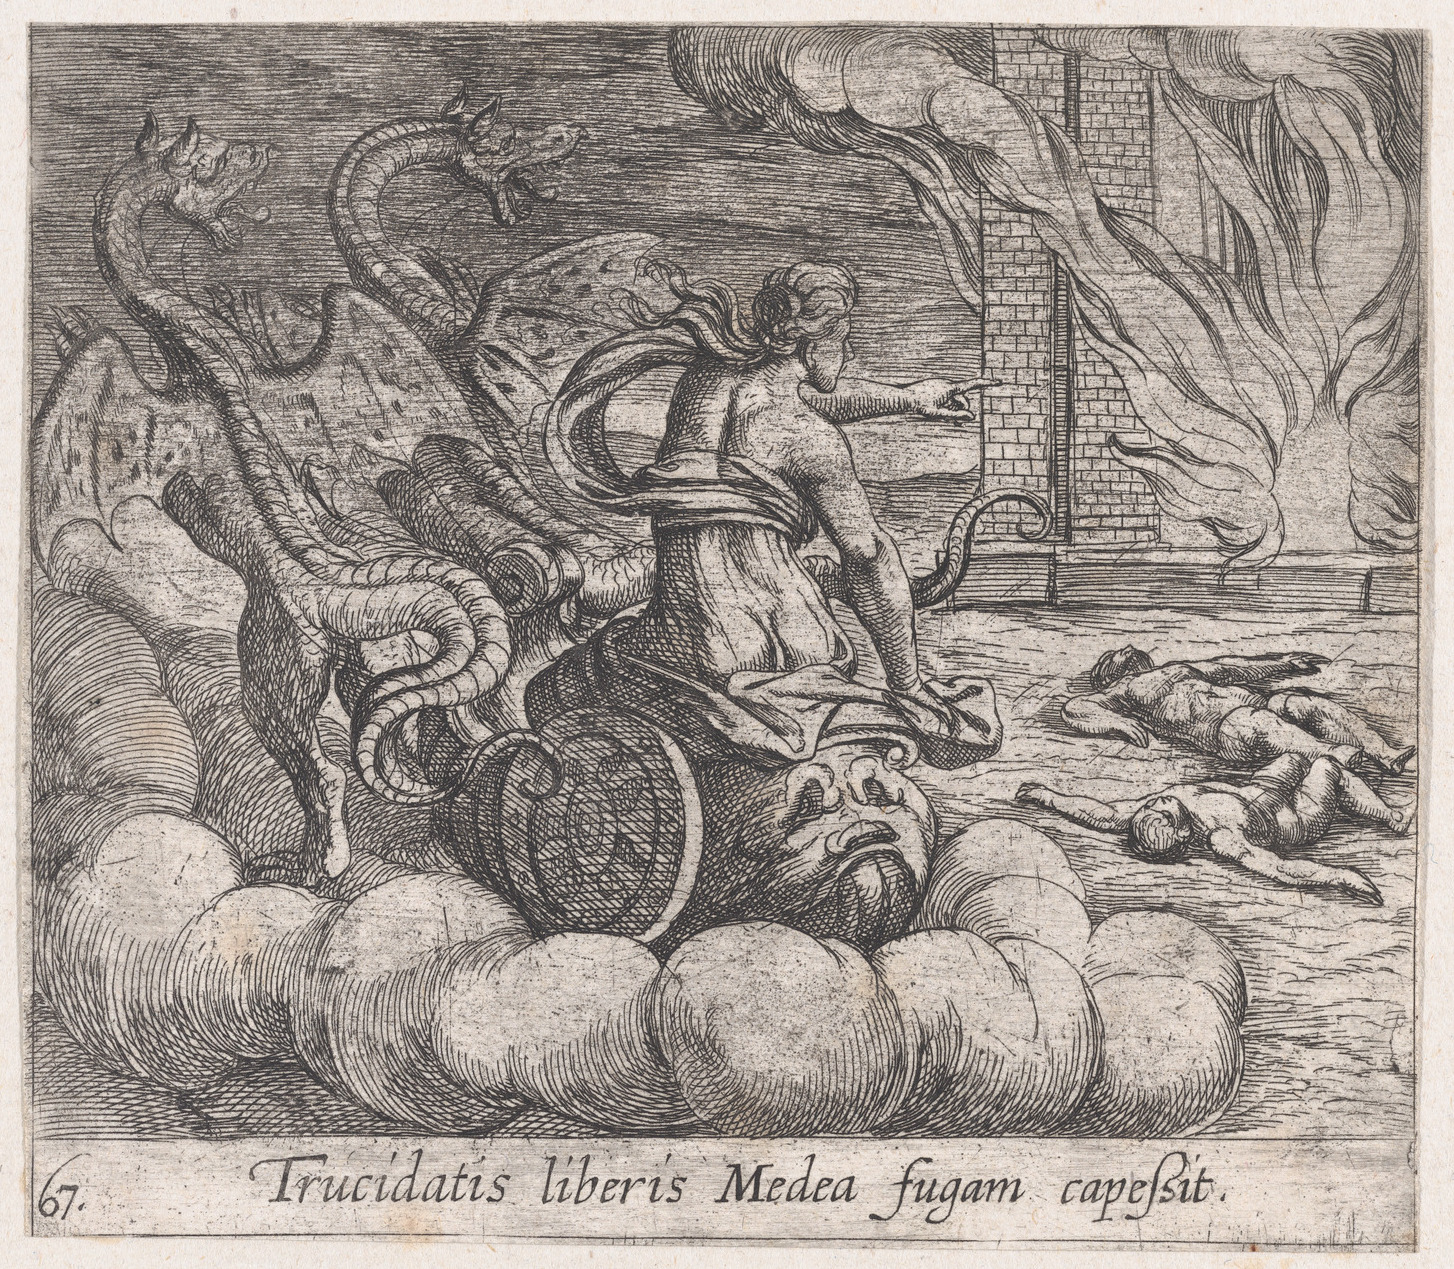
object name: print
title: Plate 67: Medea Destroying Jason's Family and Home (Trucidatis liberis Medea fugam capeßit), from Ovid's 'Metamorphoses'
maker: antonio tempesta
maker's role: artist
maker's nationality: italian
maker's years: 1555-1630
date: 1606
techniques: etching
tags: medea,dragons,fire